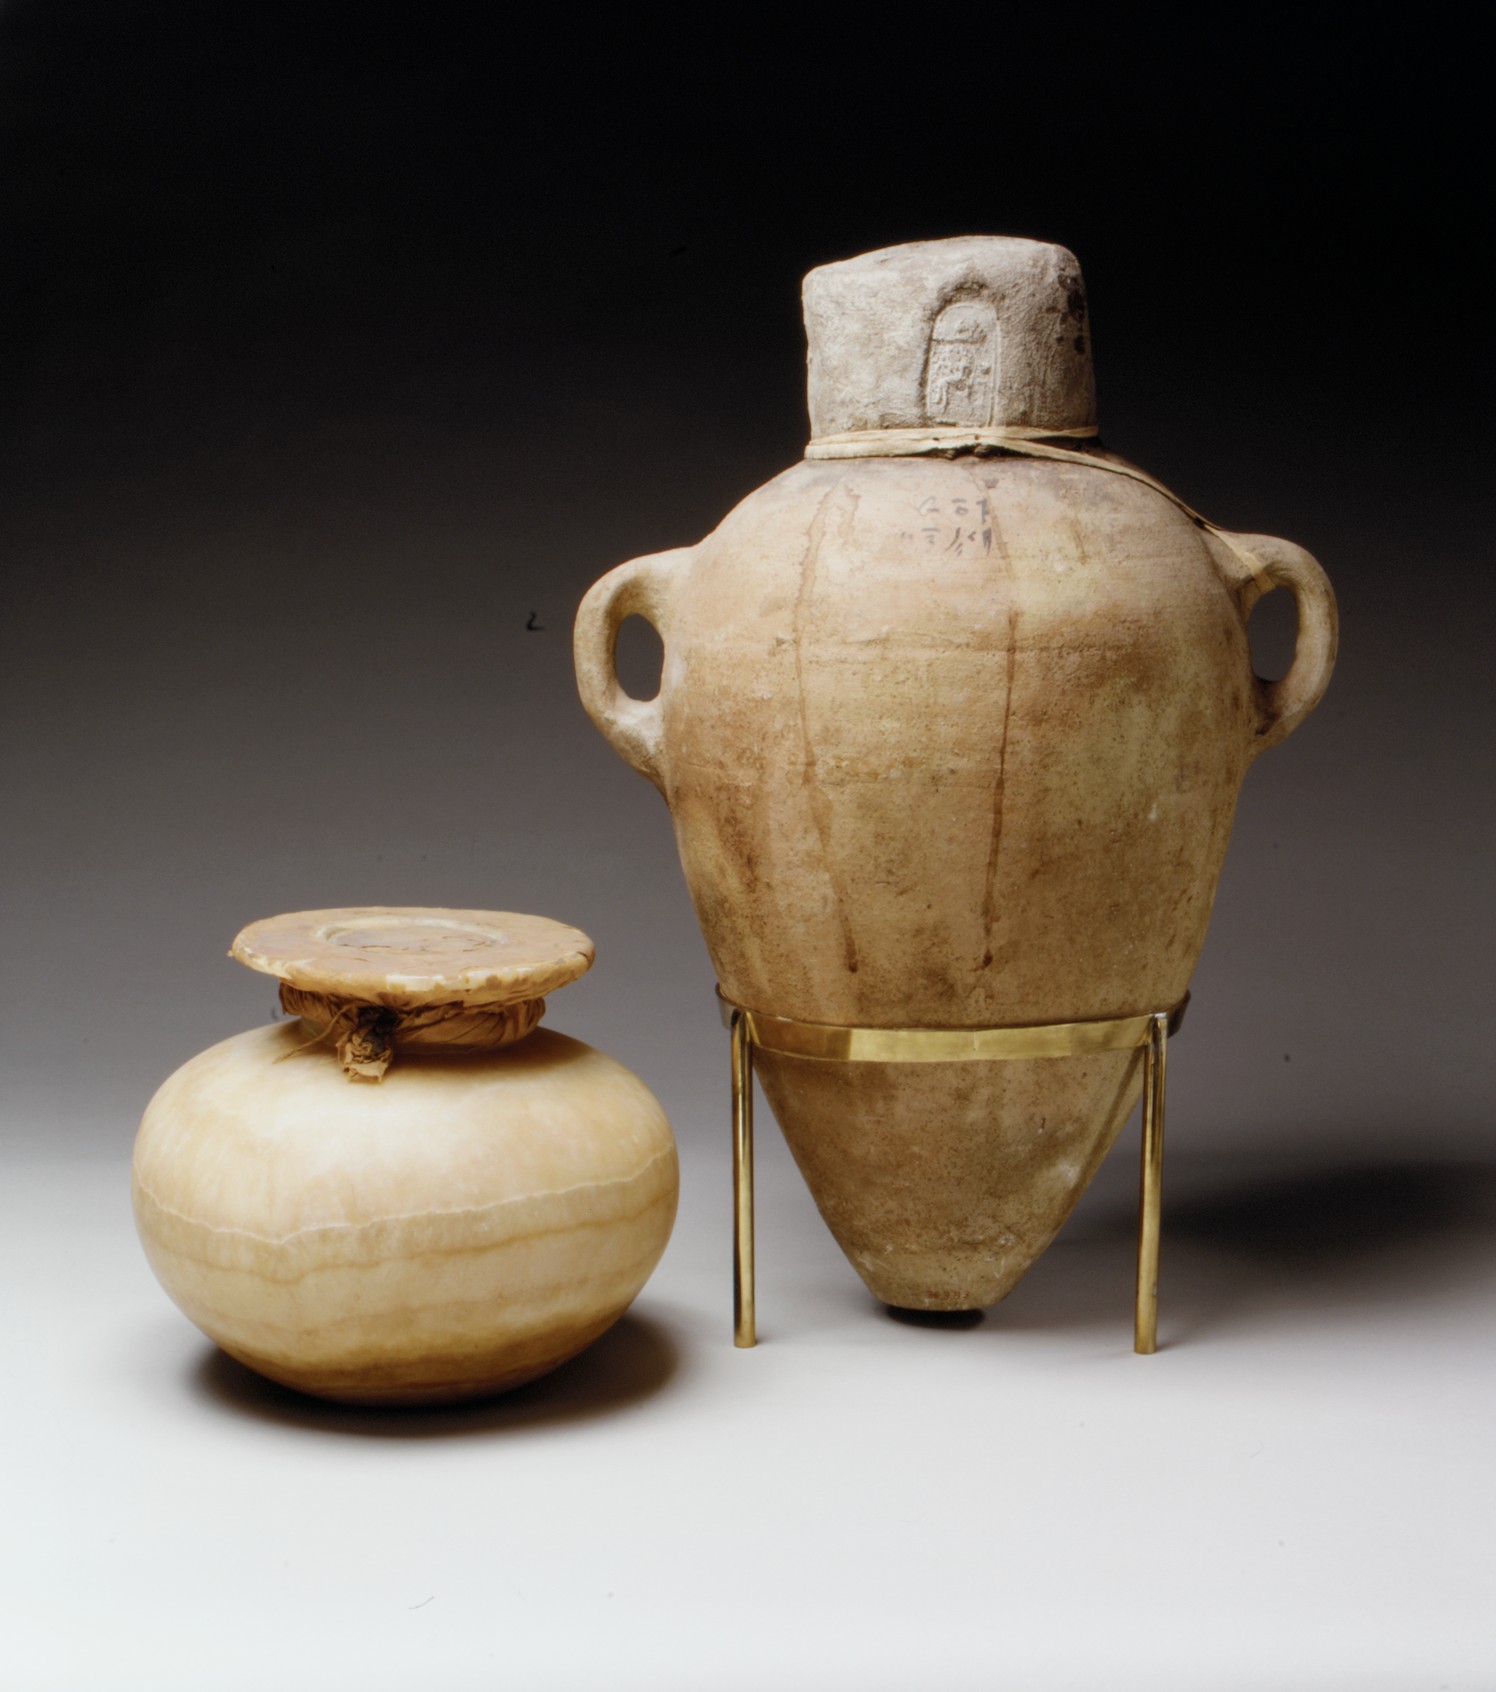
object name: large sealed storage jar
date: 1492-1473 BCE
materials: linen, mud, stone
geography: egypt